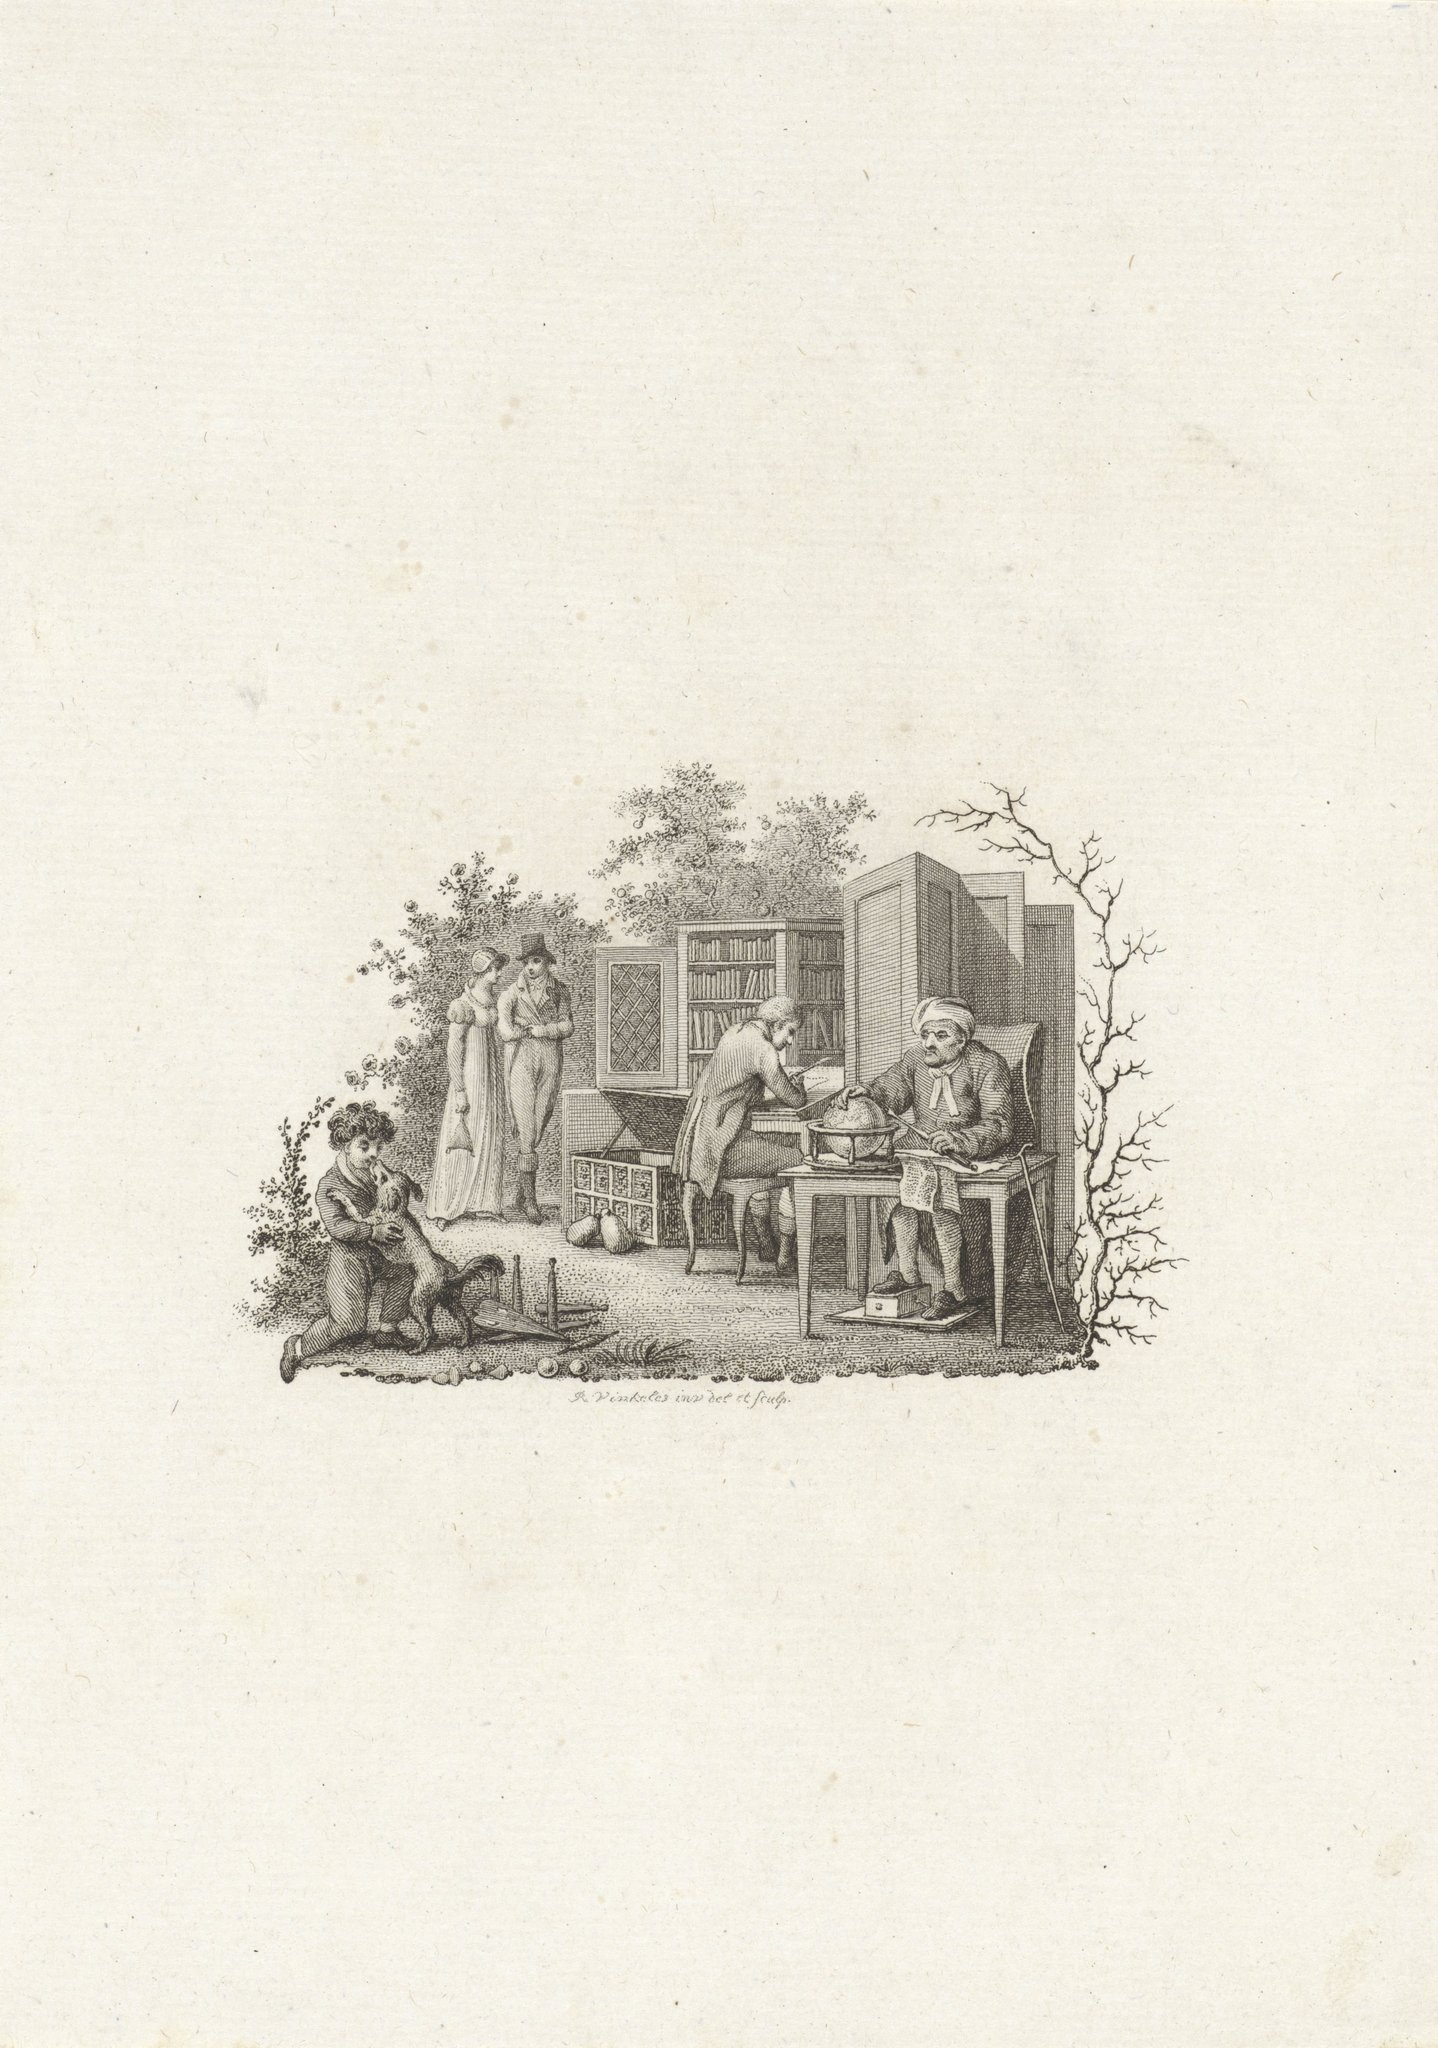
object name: print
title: Titelpagina voor: A. Loosjes, 'De man in de vier tijdperken zijns levens', 1809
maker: reinier vinkeles (i)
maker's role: draughtsman, print maker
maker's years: 1741-1816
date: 1809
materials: paper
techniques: engraving, etching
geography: amsterdam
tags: the ages of man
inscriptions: collector's mark: Lugt 2228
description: Proefdruk van titelpagina voor: Loosjes, Adriaan Pietersz. De man in de vier tijdperken zijns levens. Haarlem: Adriaan Pietersz. Loosjes, 1809.